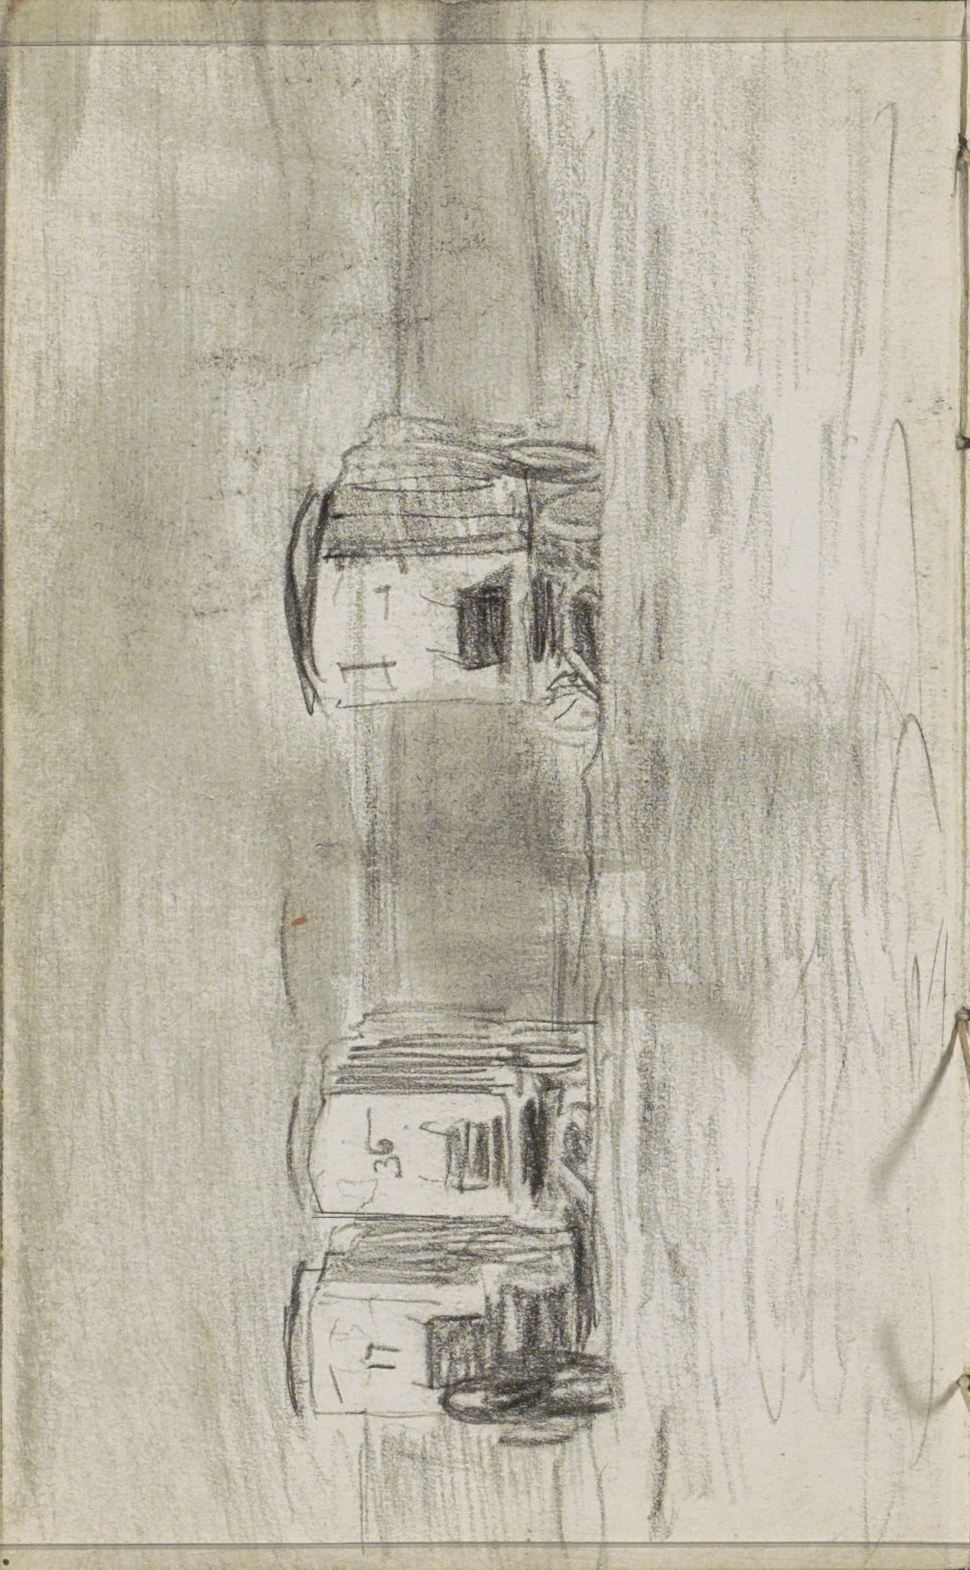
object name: sketchbook leaf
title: Badkoetsen op het strand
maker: anton mauve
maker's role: draughtsman, painter, print maker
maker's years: 1838-1888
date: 1848-1888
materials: chalk, paper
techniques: brush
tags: four-wheeled, animal-drawn vehicle, e.g.: cab, carriage, coach, beach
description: Blad 9 verso uit een schetsboek met 53 bladen.